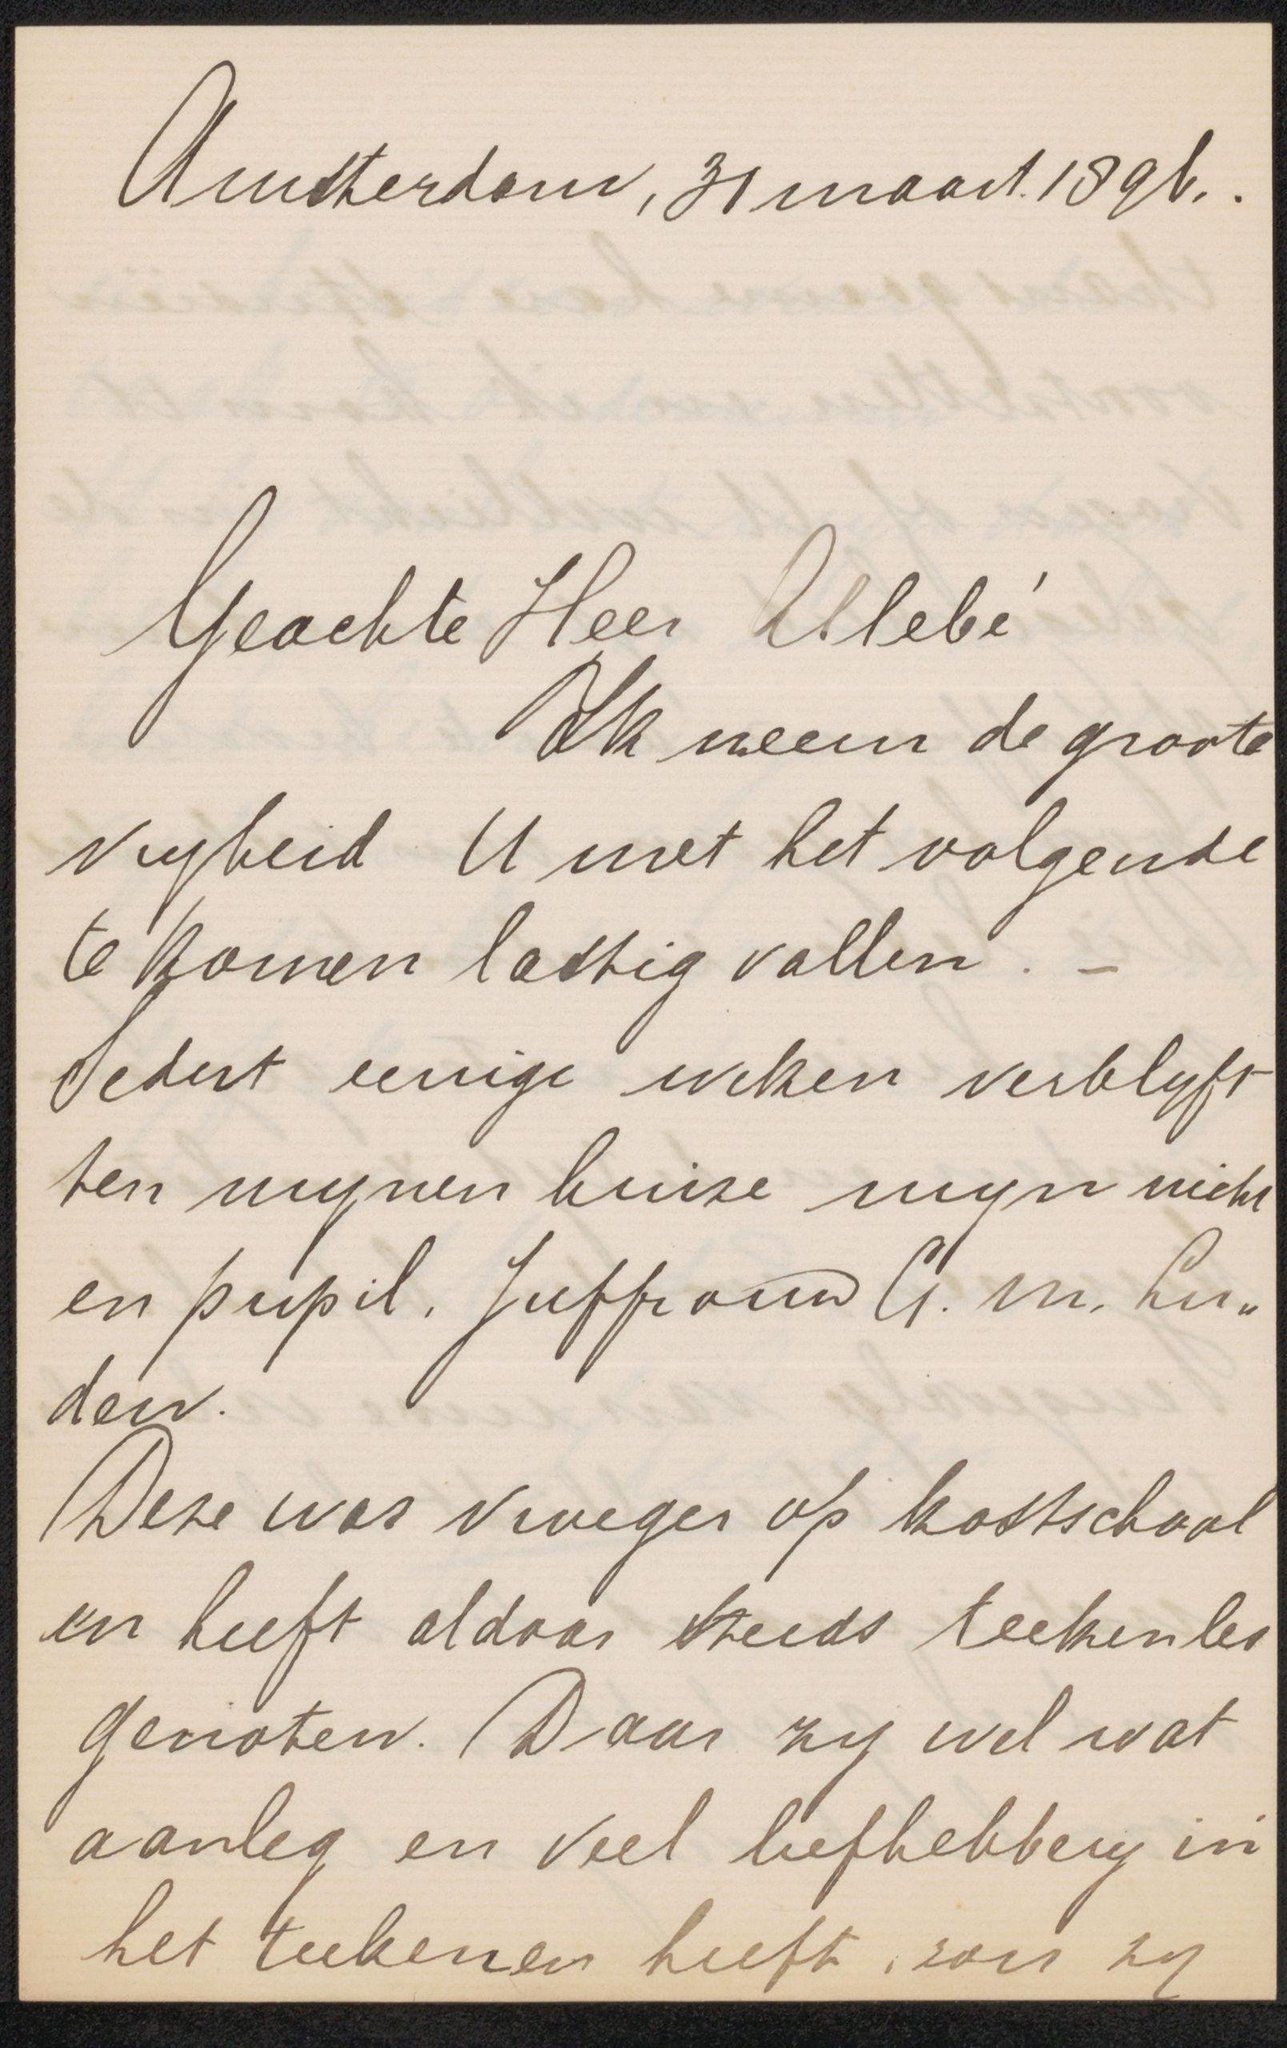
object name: letter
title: Brief aan August Allebé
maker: j. luden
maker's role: artist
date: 1896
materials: ink, paper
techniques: pen, writing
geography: amsterdam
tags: amsterdam, print maker, draughtsman, august allebé, drawing, education, tuition of the artist (in general)